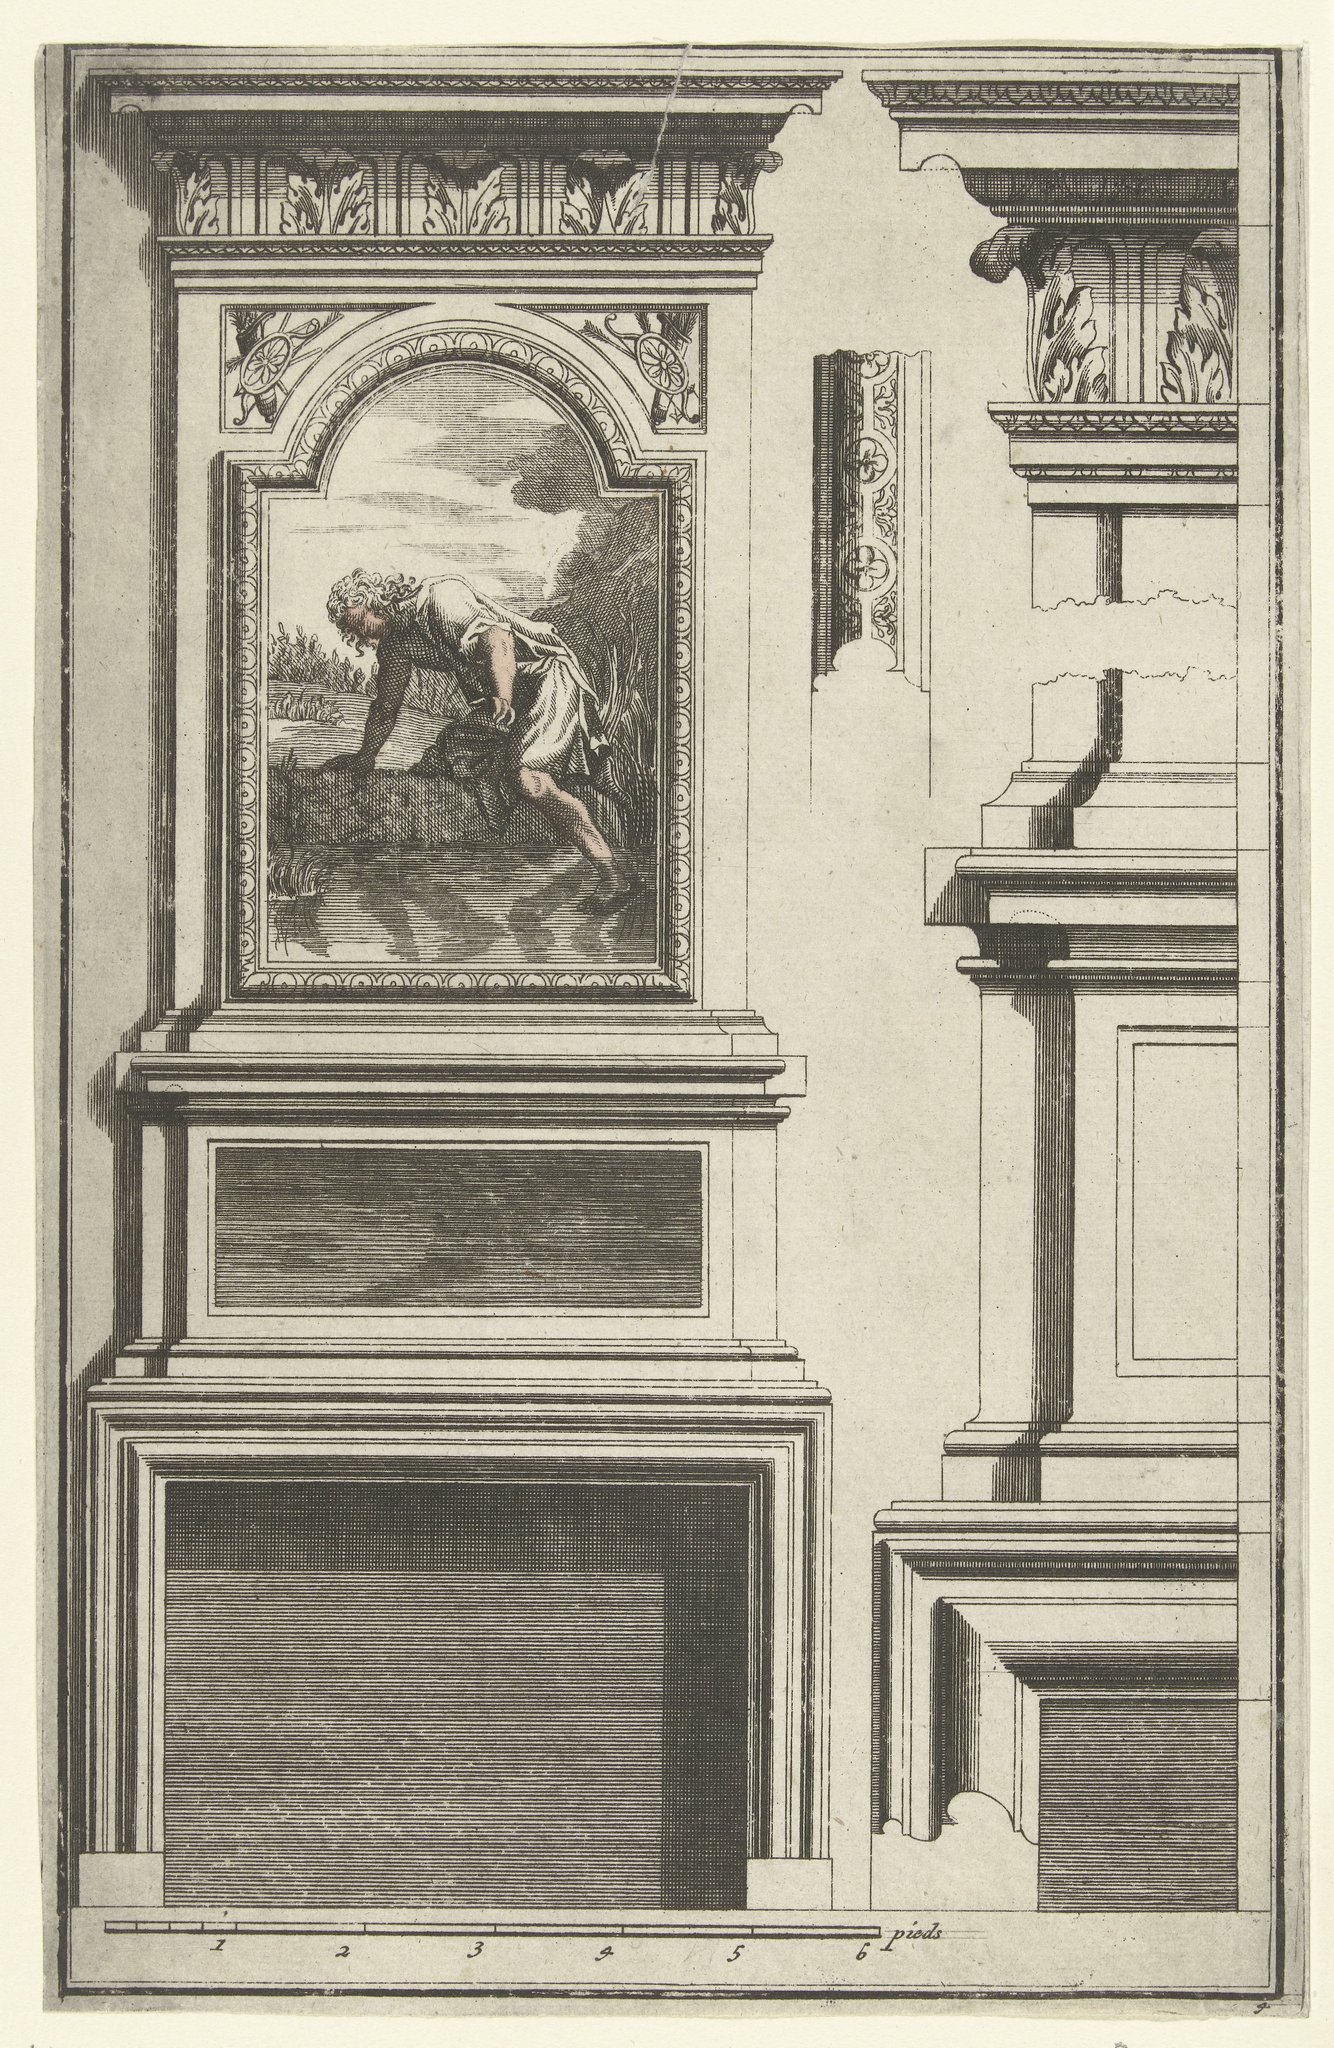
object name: print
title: Onderboezem met schilderij van Narcissus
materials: paper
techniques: etching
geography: netherlands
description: Rechts zijn verschillende details afgebeeld.